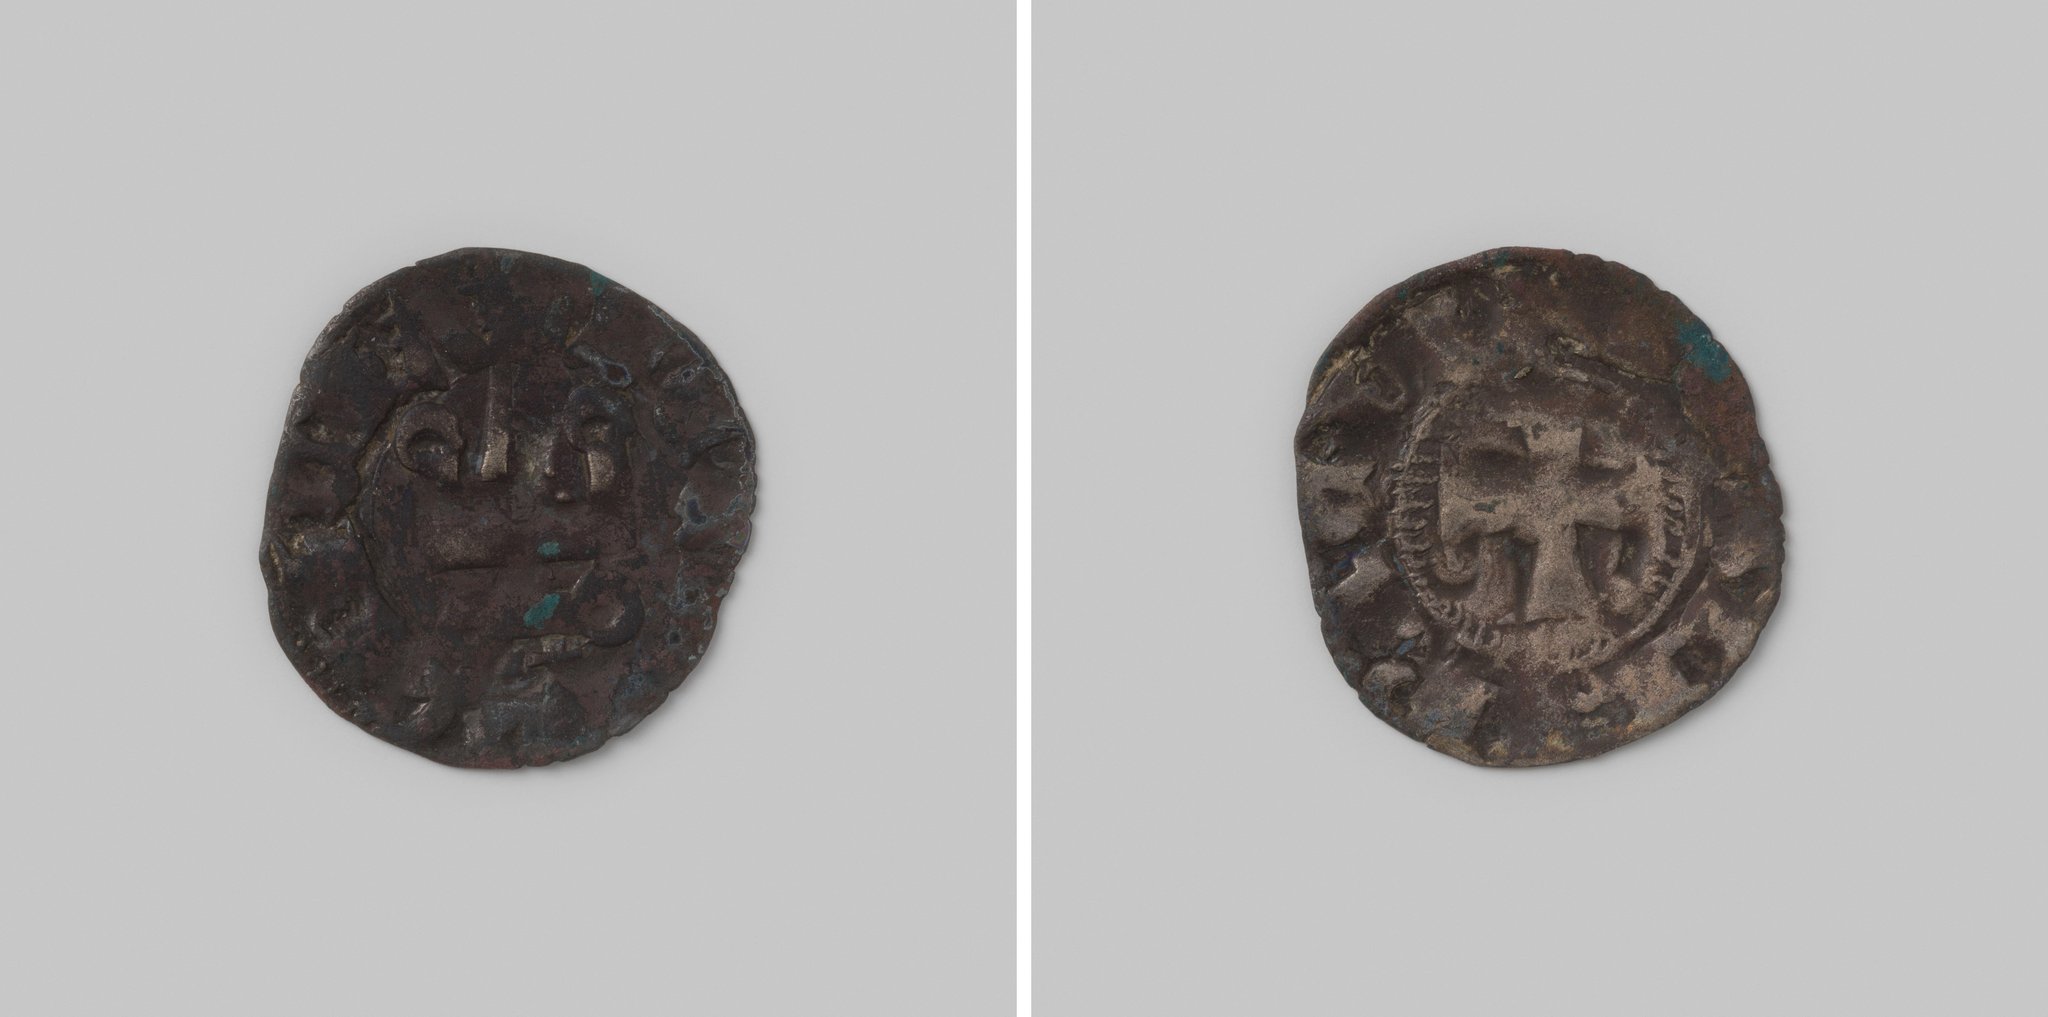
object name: coin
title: Vorstendom Achaea, tourse penning, Philippe van Tarento,1307-1313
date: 1307-1313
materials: silver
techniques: striking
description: Zilveren munt. Voorzijde: kasteel met drie torens, boven middelste, spitse toren kruis als begin van het omschrift. Keerzijde: kort gevoet kruis. Geslagen in Clarenza.